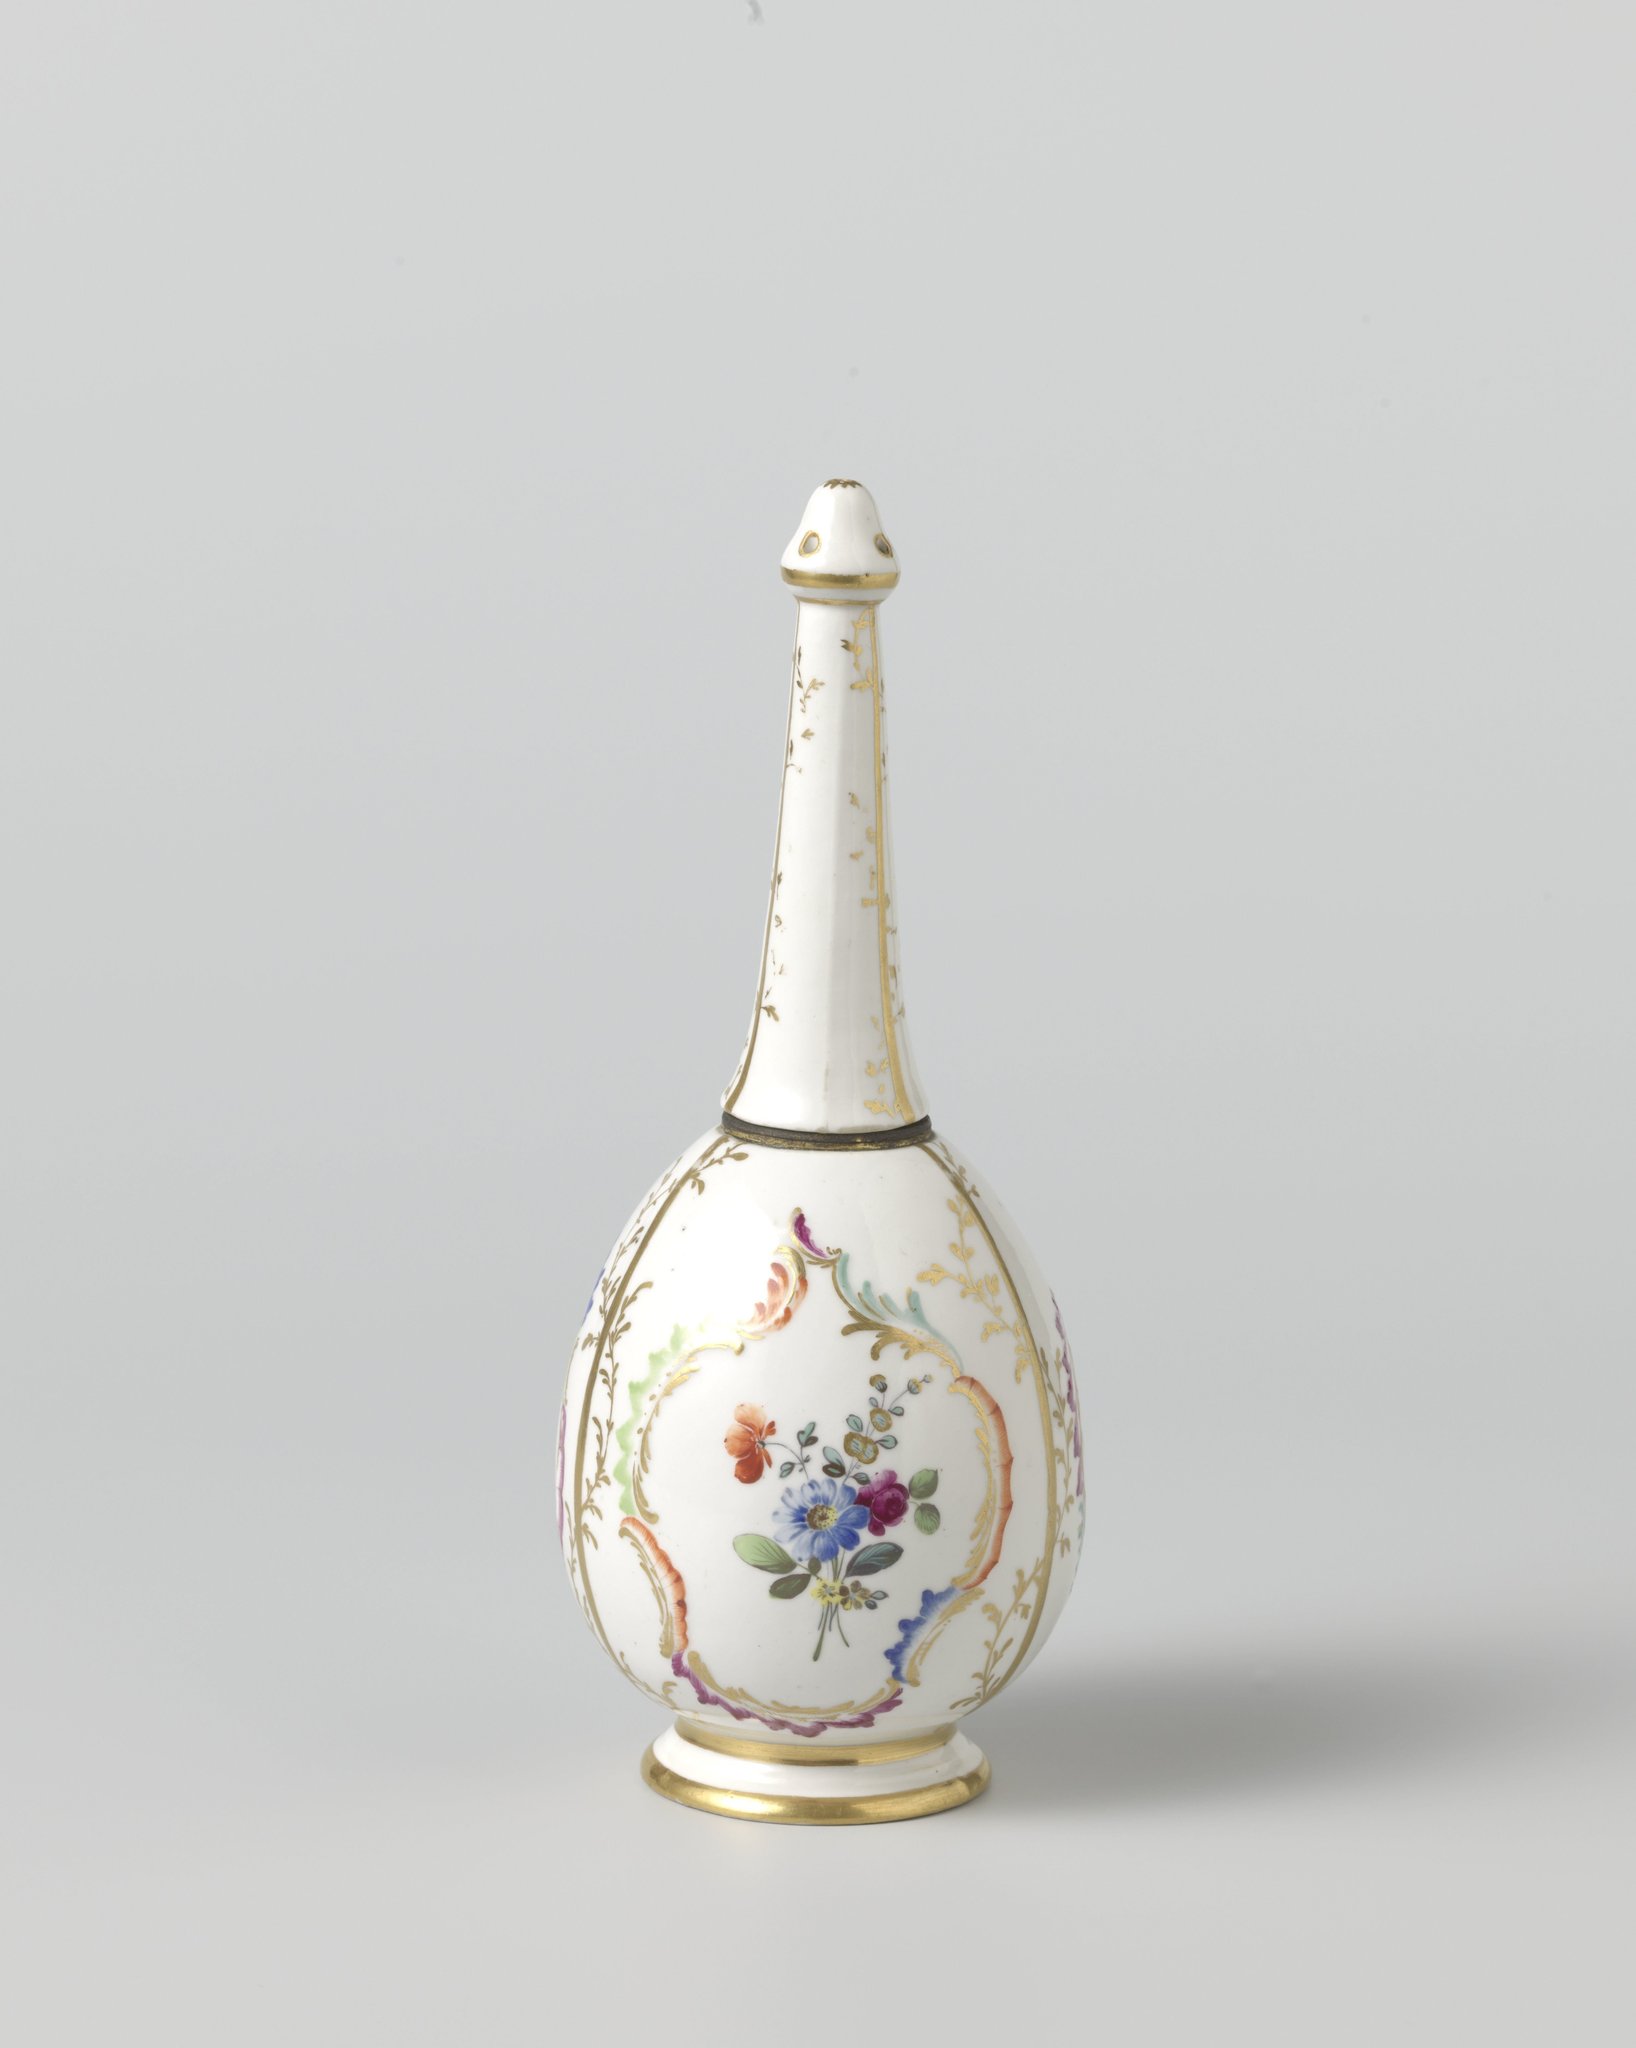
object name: strooibus, strooier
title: Pruikenpoederstrooier van veelkleurig beschilderd Meissen porselein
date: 1750-1775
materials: porcelain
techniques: painted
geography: meissen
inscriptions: factory mark, mold mark: ‘10’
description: Wig powder sprinkler. Porcelain. Meissen, c. 1750 - 1775. Given by the Commissie voor Fotoverkoop, 1953.